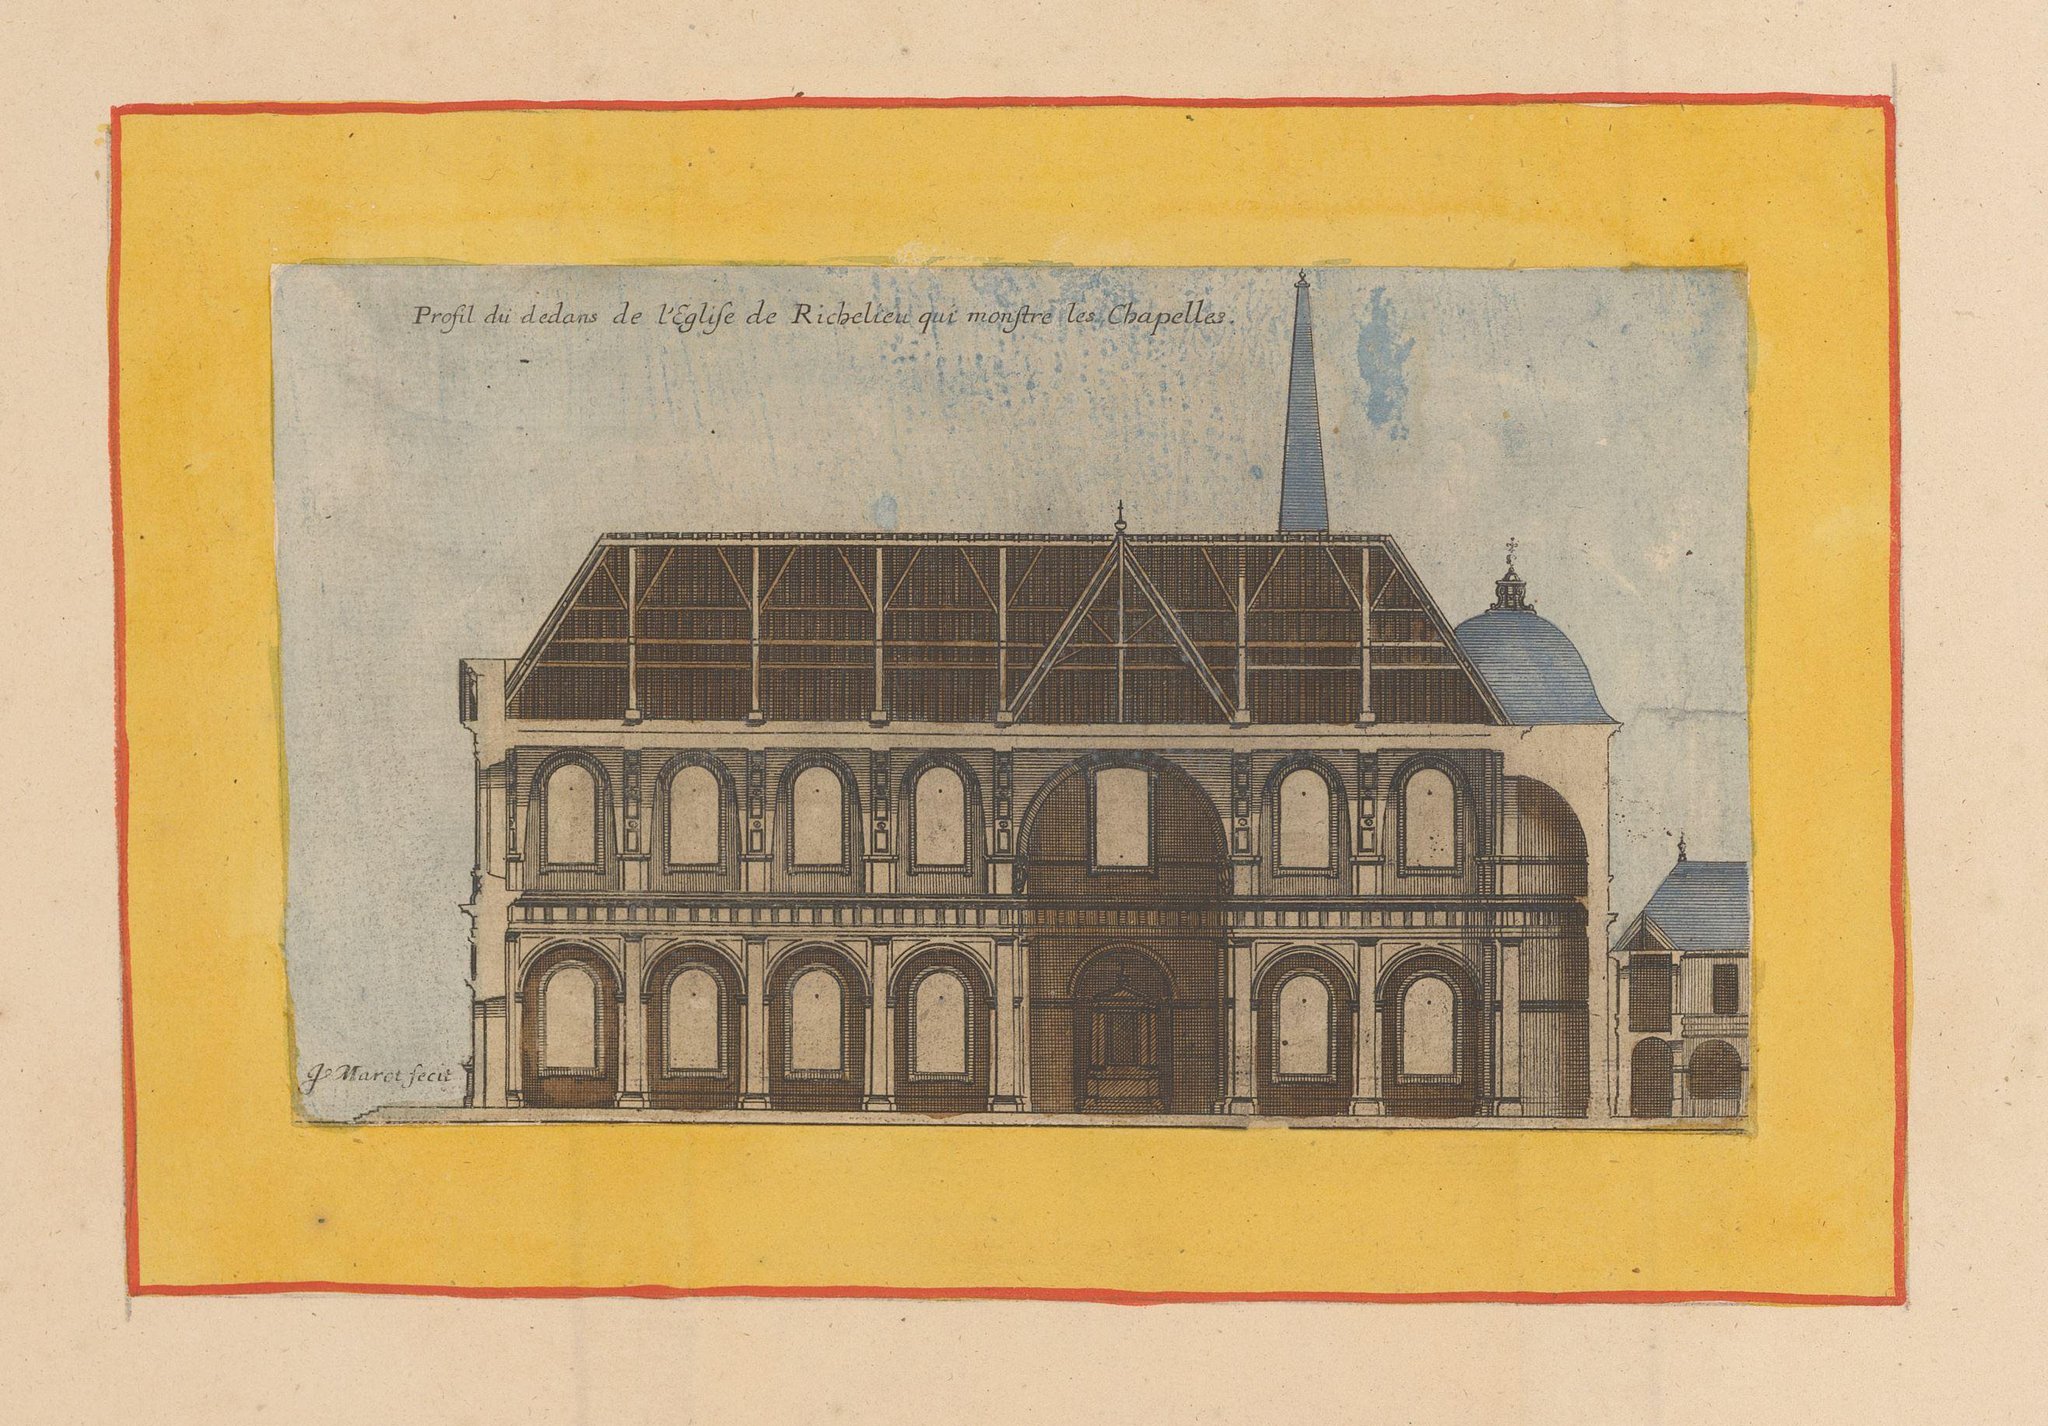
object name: print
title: Doorsnede van de kerk van Richelieu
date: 1629-1679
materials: paper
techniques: etching, hand coloring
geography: the hague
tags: church (exterior), series of designs, models, etc. of one architectural project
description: Deze prent maakt deel uit van een album.